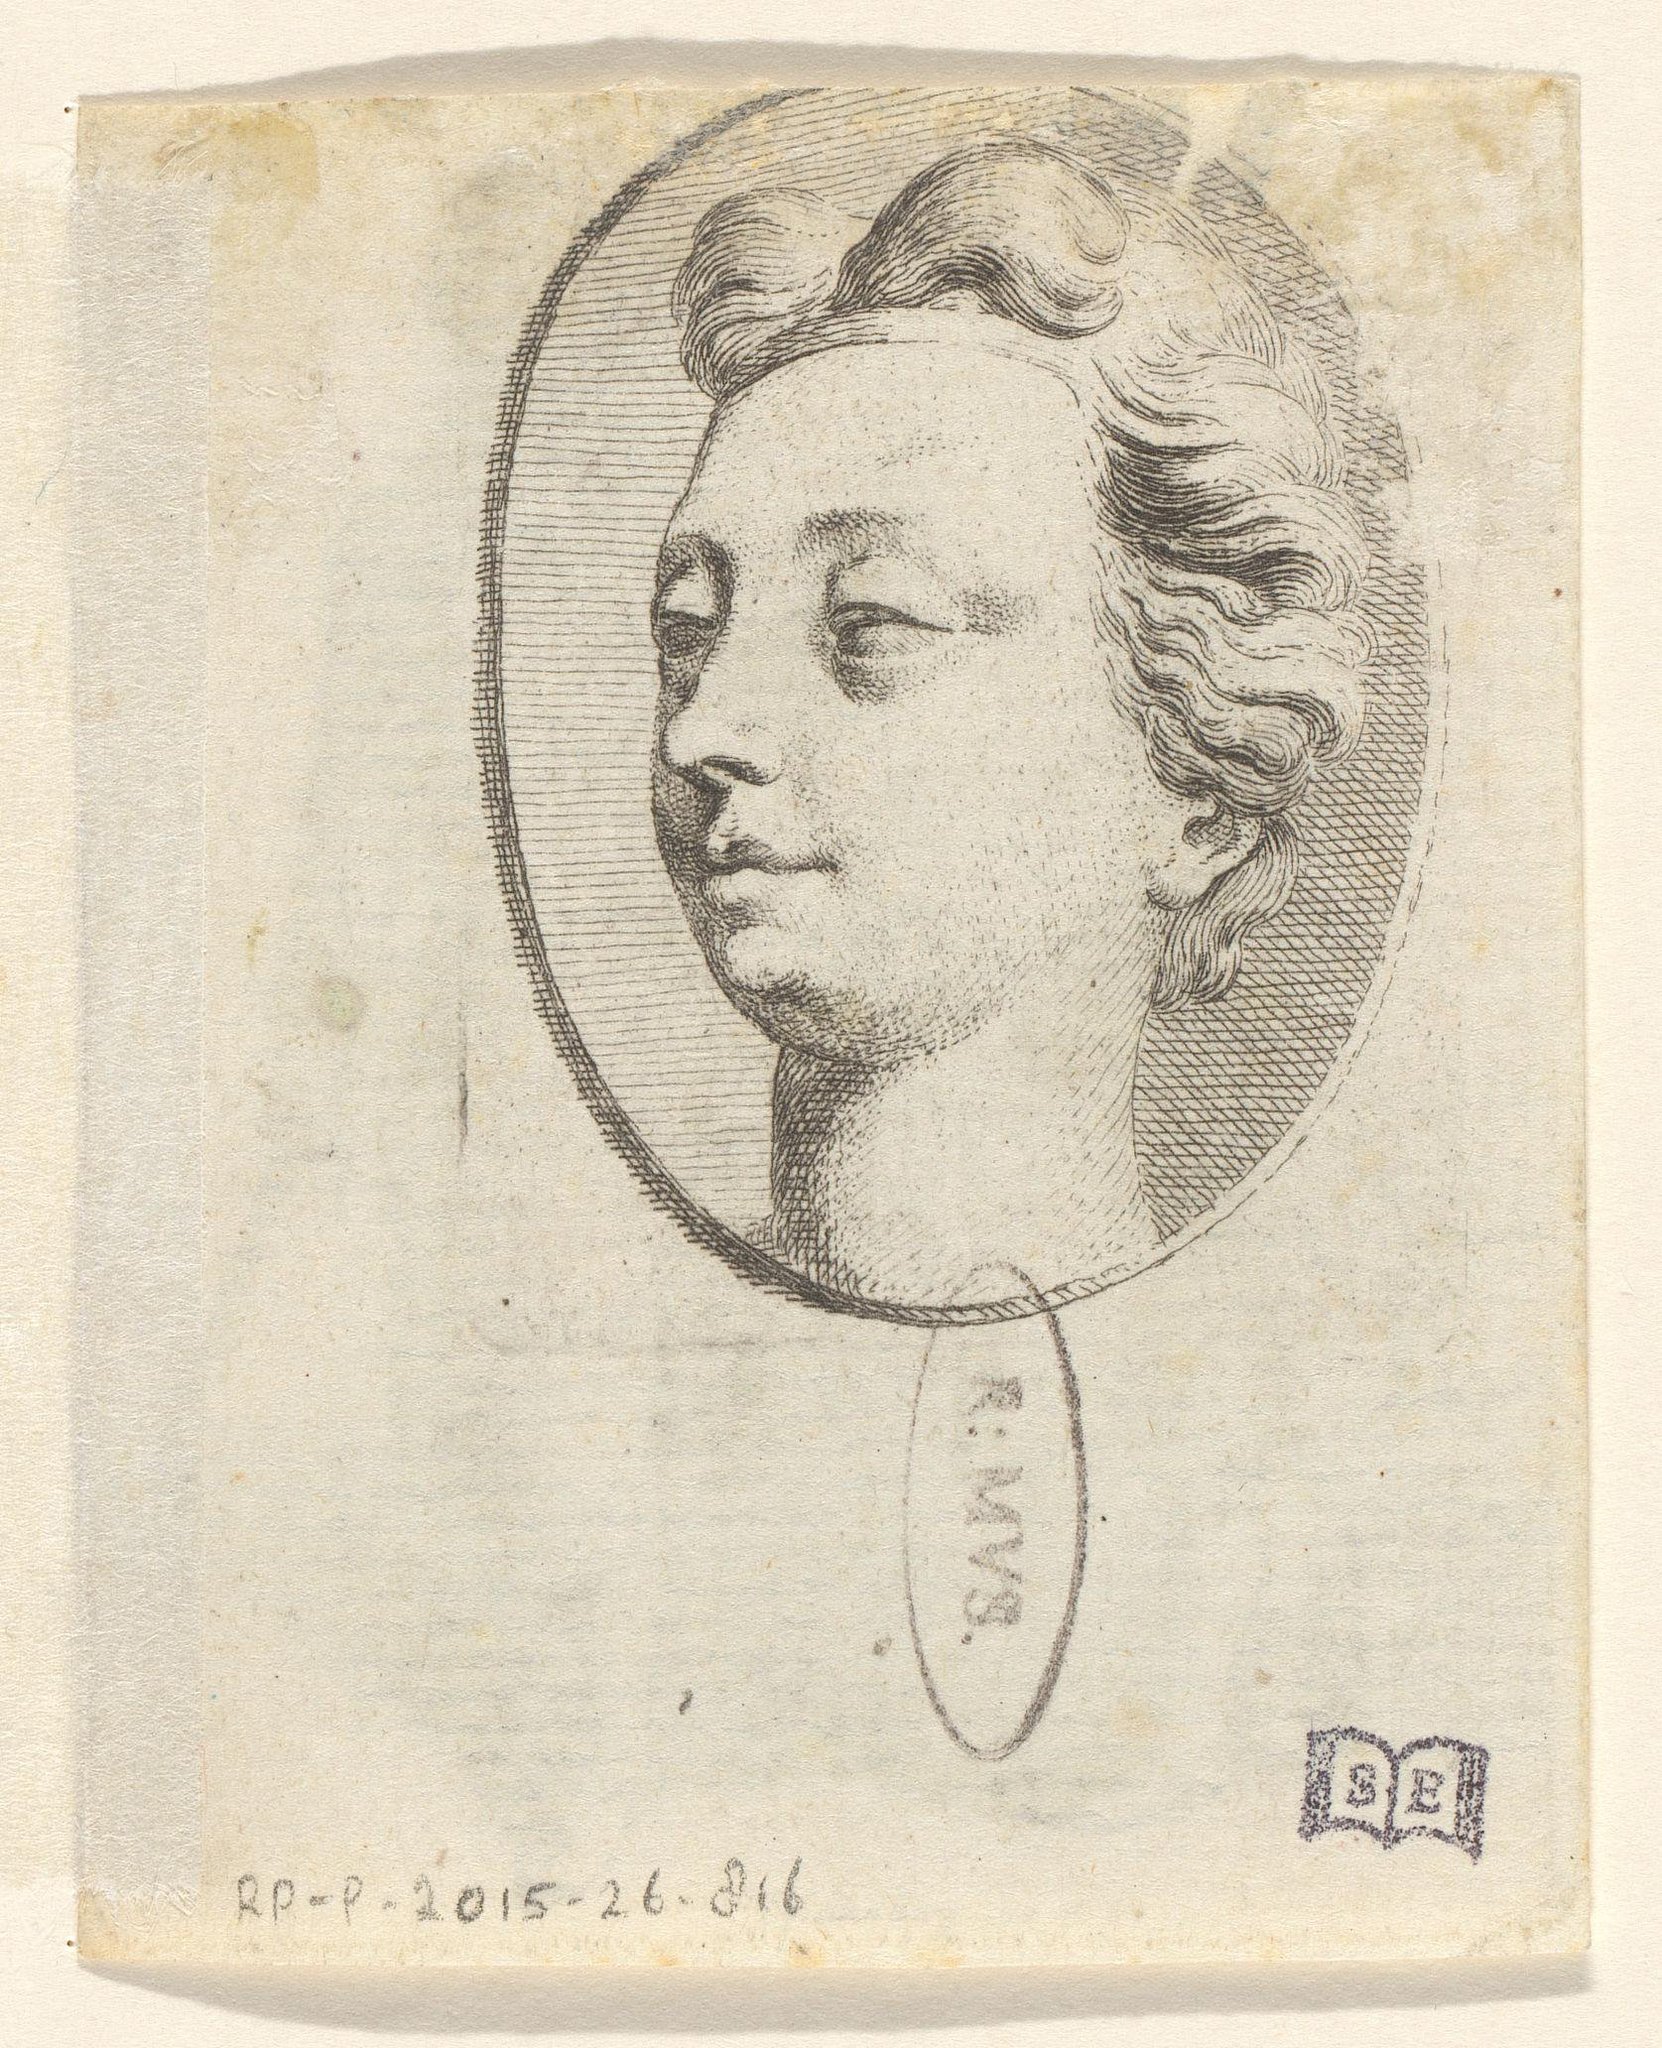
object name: print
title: Vrouwengezicht in een ovaal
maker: johann rudolph schellenberg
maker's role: print maker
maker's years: 1740-1806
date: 1750-1806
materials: paper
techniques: etching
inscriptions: collector's mark: Lugt 2228, collector's mark: Lugt 4780